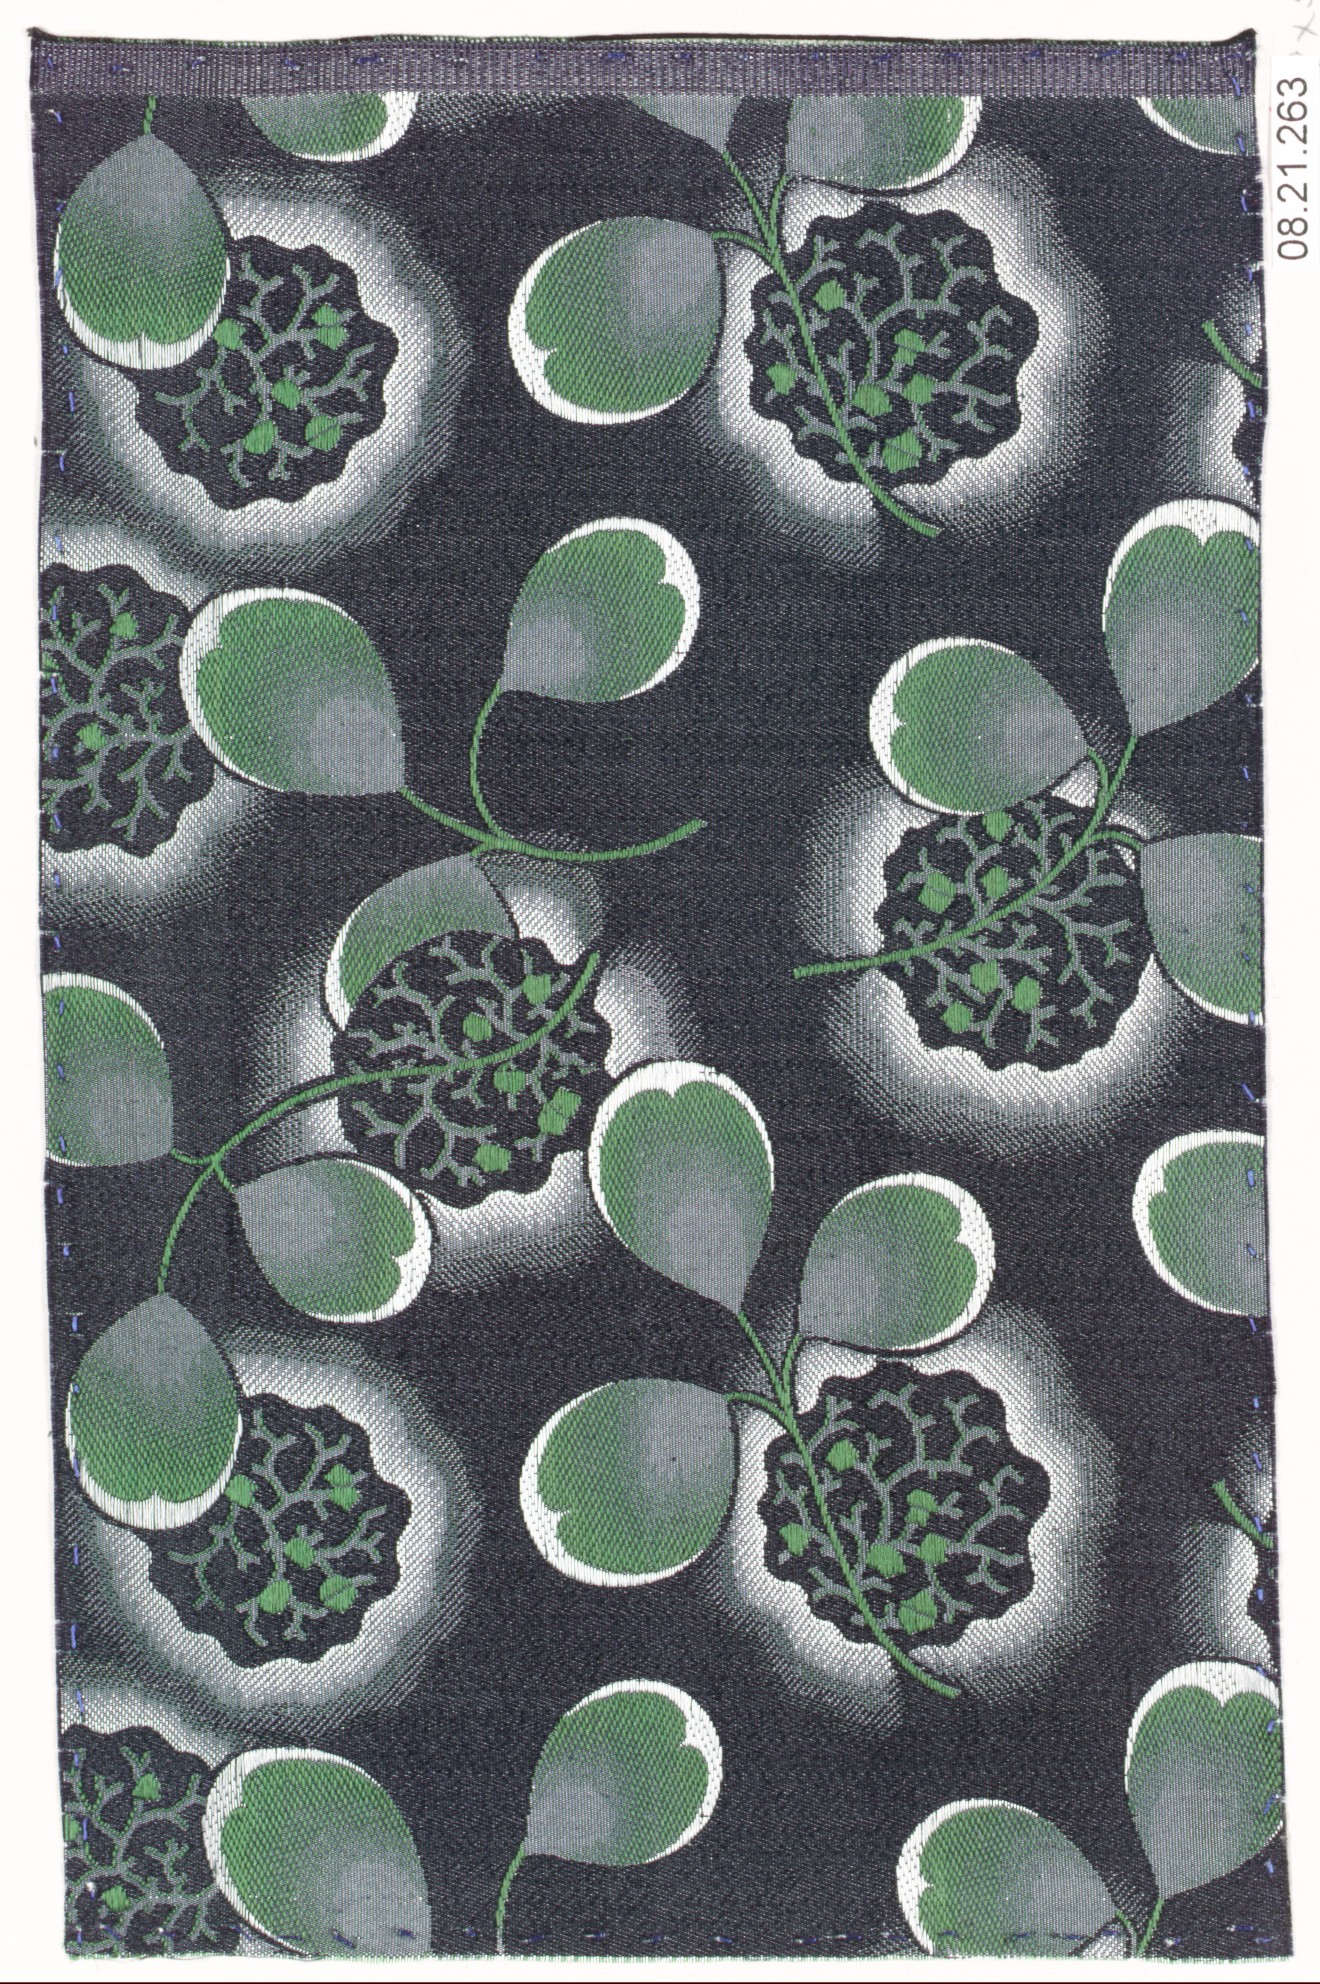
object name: textile sample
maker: Anonymous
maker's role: designer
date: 1900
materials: silk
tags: flowers